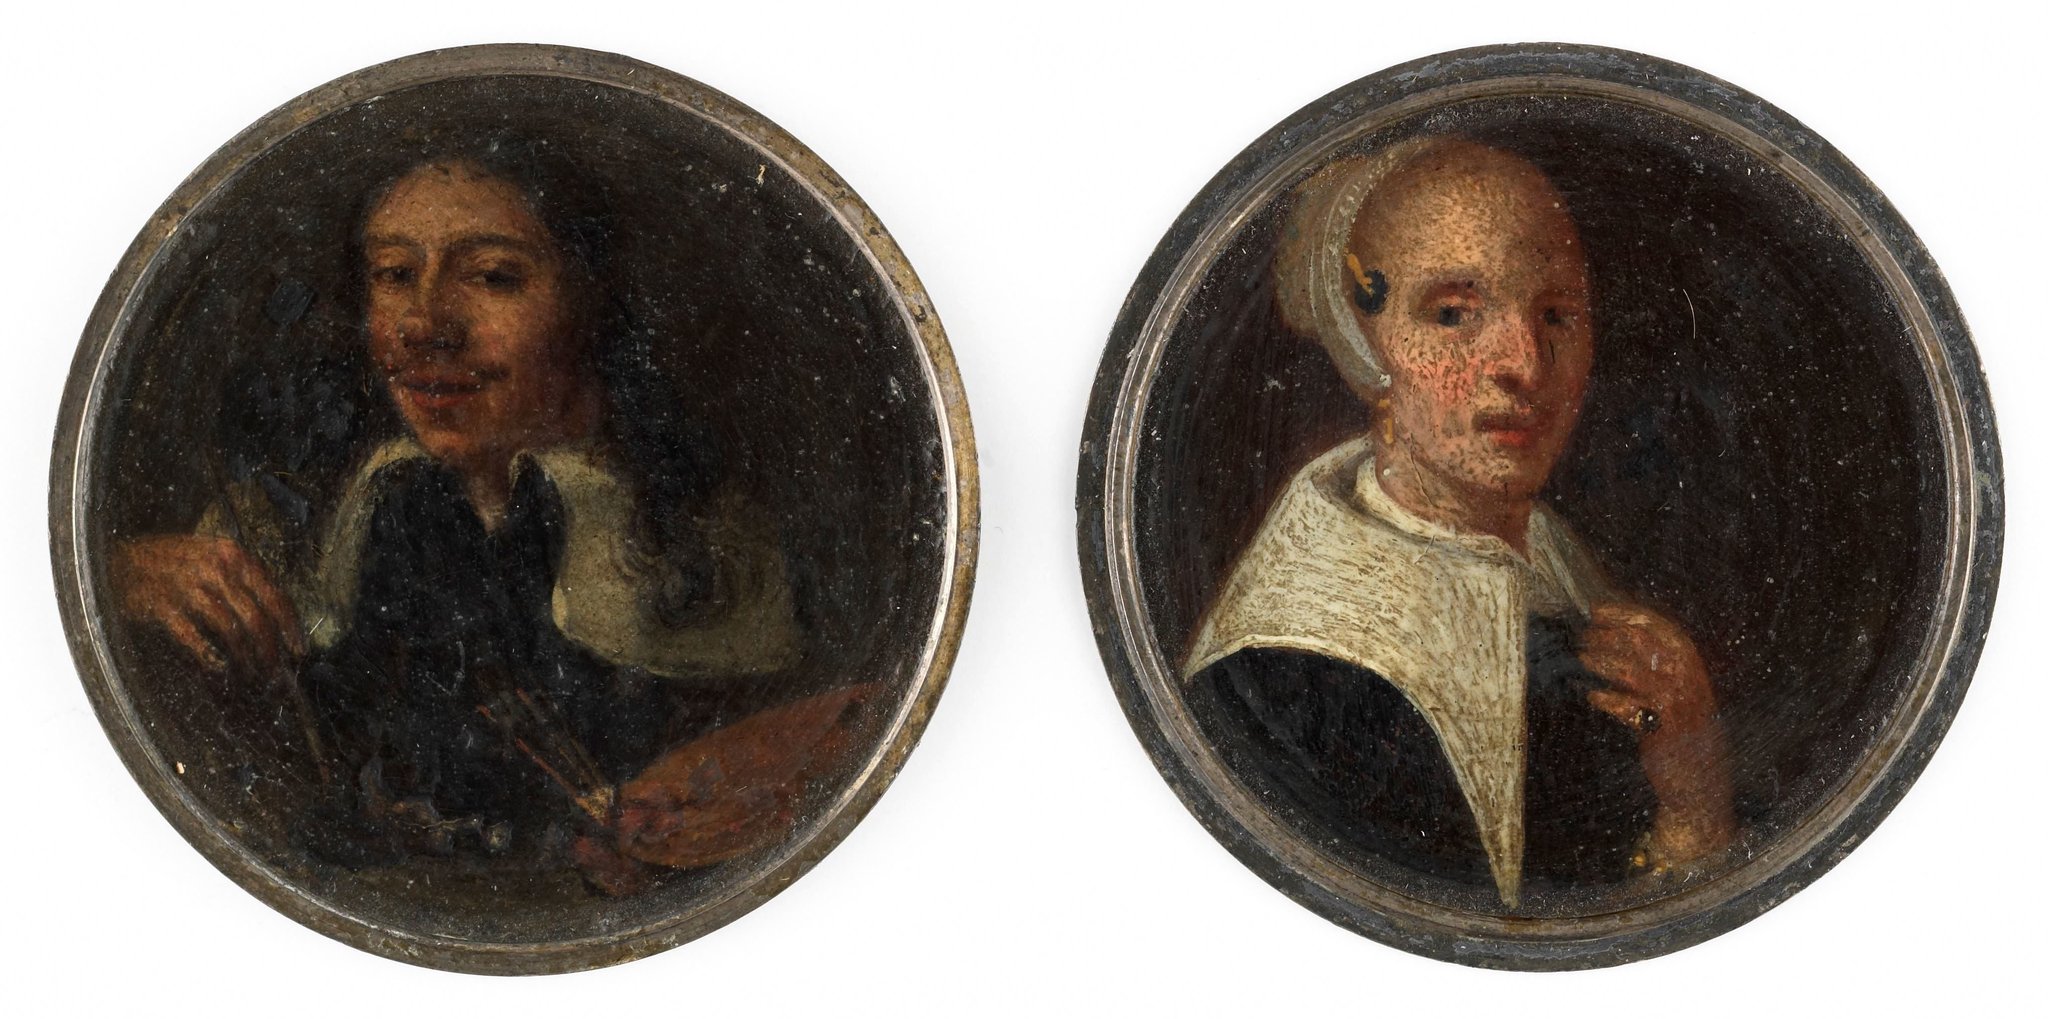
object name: schroefdaalder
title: Zelfportret van Johann Philip Lembke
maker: johann philipp lemke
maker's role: painter, print maker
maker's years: 1631-1711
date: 1650-1713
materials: oil, silver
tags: johann philipp lemke, portrait, self-portrait of artist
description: Zelfportret van Johann Philip Lembke (1631-1713). In buste, naar links met palet en penselen in de hand. Geschilderd op de binnenzijden van een zilveren schroefdaalder uit 1632. Onderdeel van de collectie portretminiaturen.